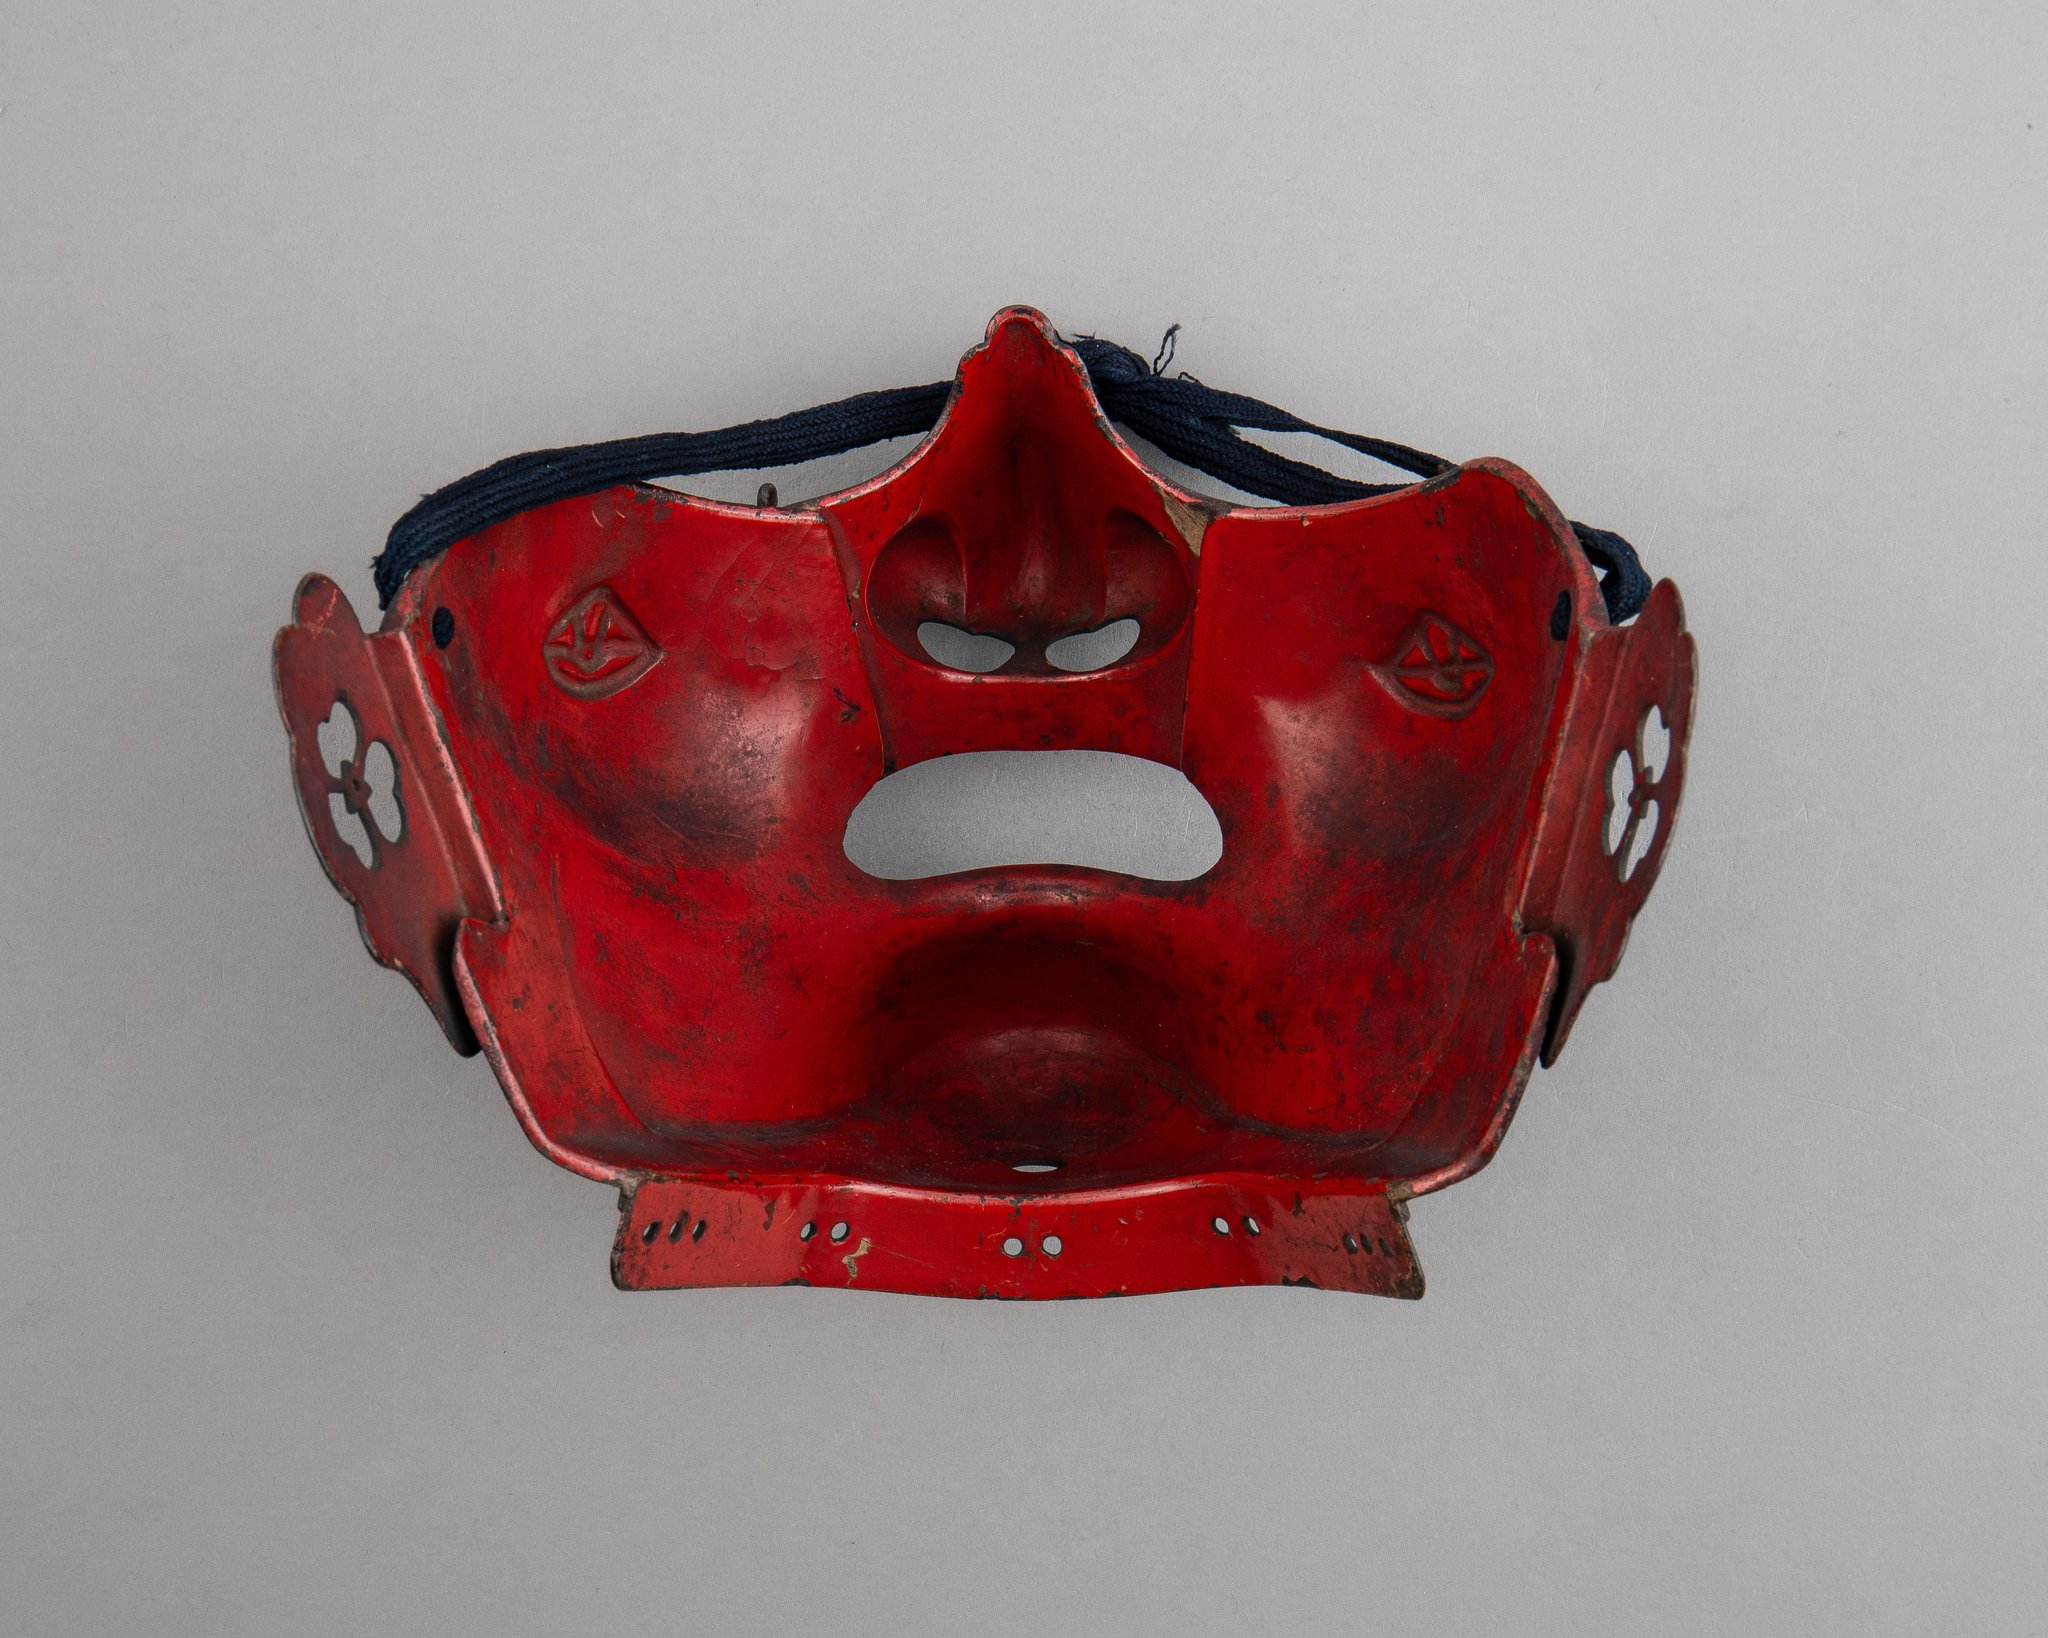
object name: half mask menpō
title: Half Mask (Menpō)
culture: japanese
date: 1615-1868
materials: iron, lacquer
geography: japan